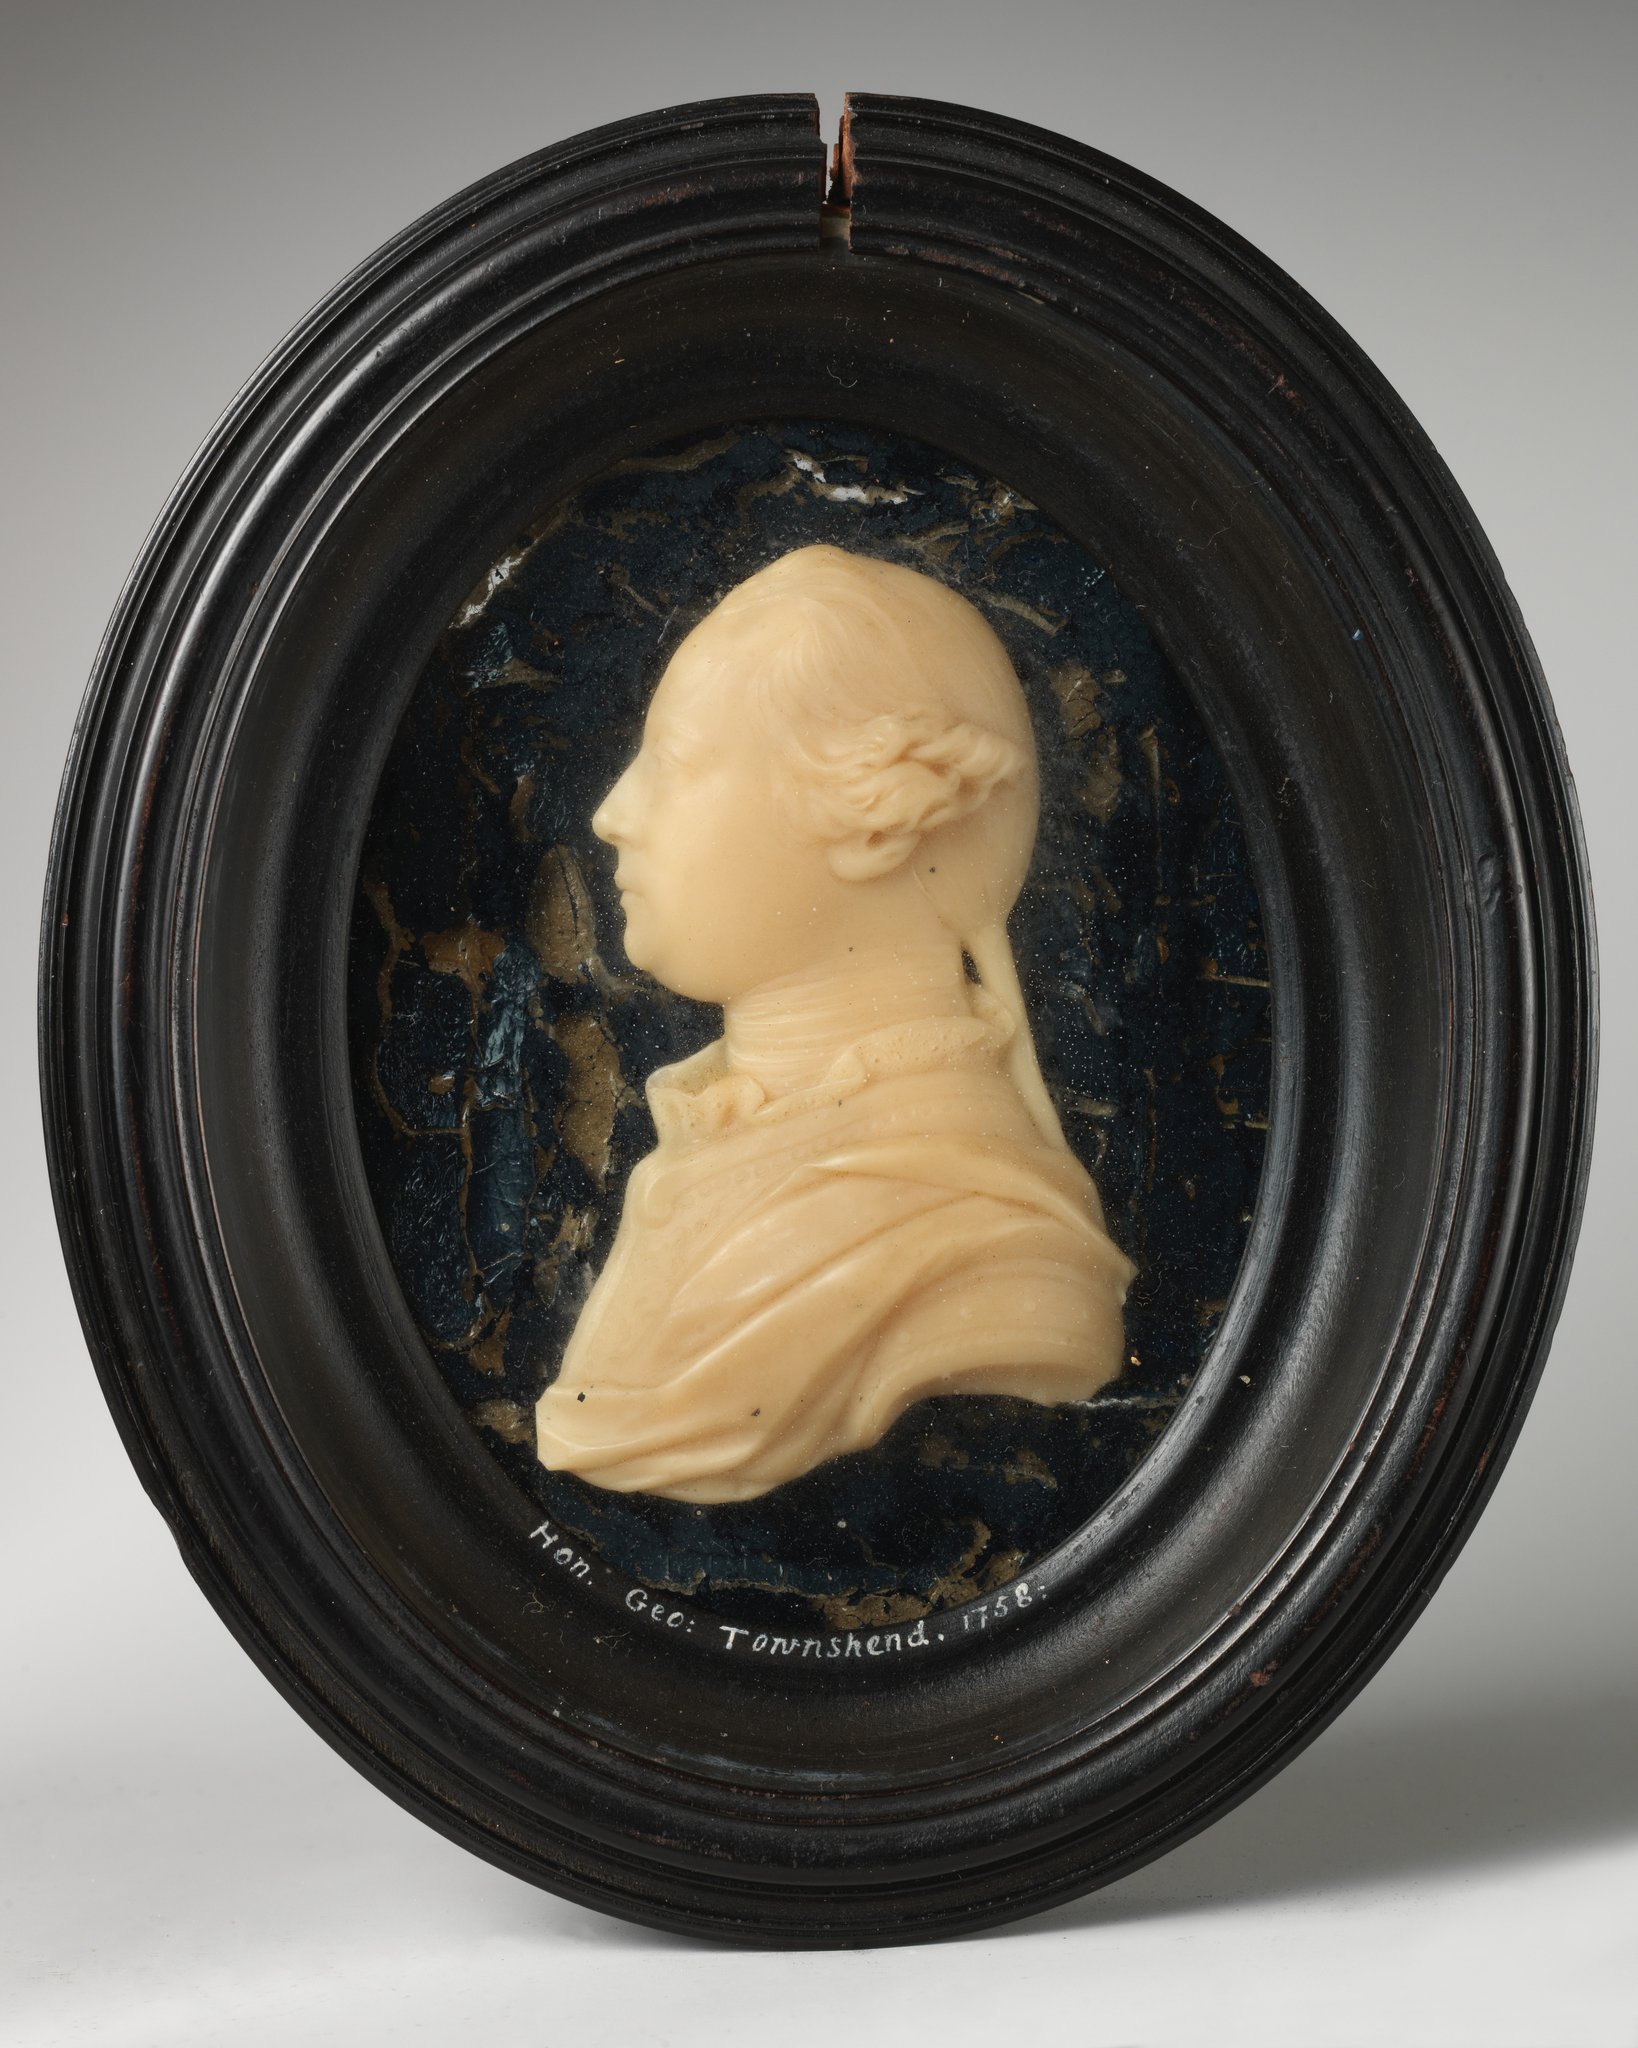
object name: medallion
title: George Townshend (1724–1807)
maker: isaac gosset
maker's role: maker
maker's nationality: british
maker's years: 1713-1799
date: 1758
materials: glass, wax, wood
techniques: painting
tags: men,profiles